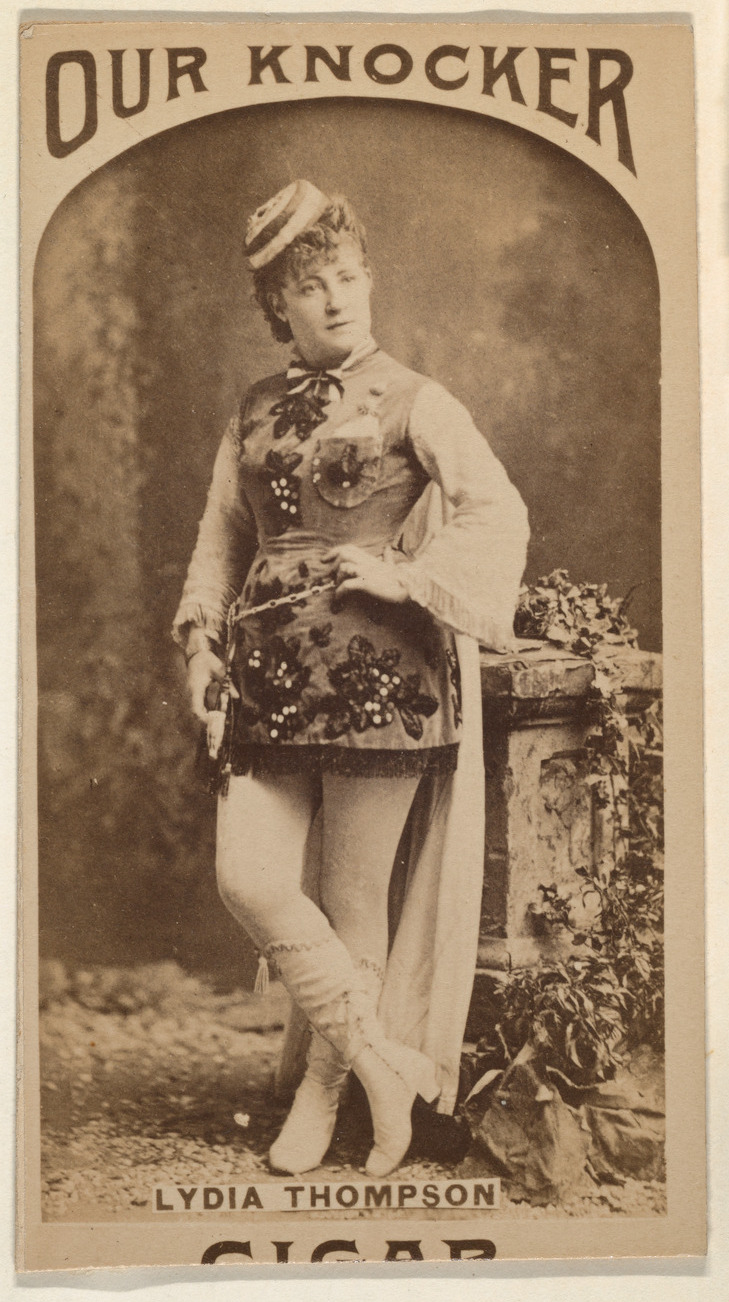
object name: photograph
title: Lydia Thompson, from the Actresses series (N665) promoting Our Knocker Cigars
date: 1888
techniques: albumen silver print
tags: portraits,women,actresses